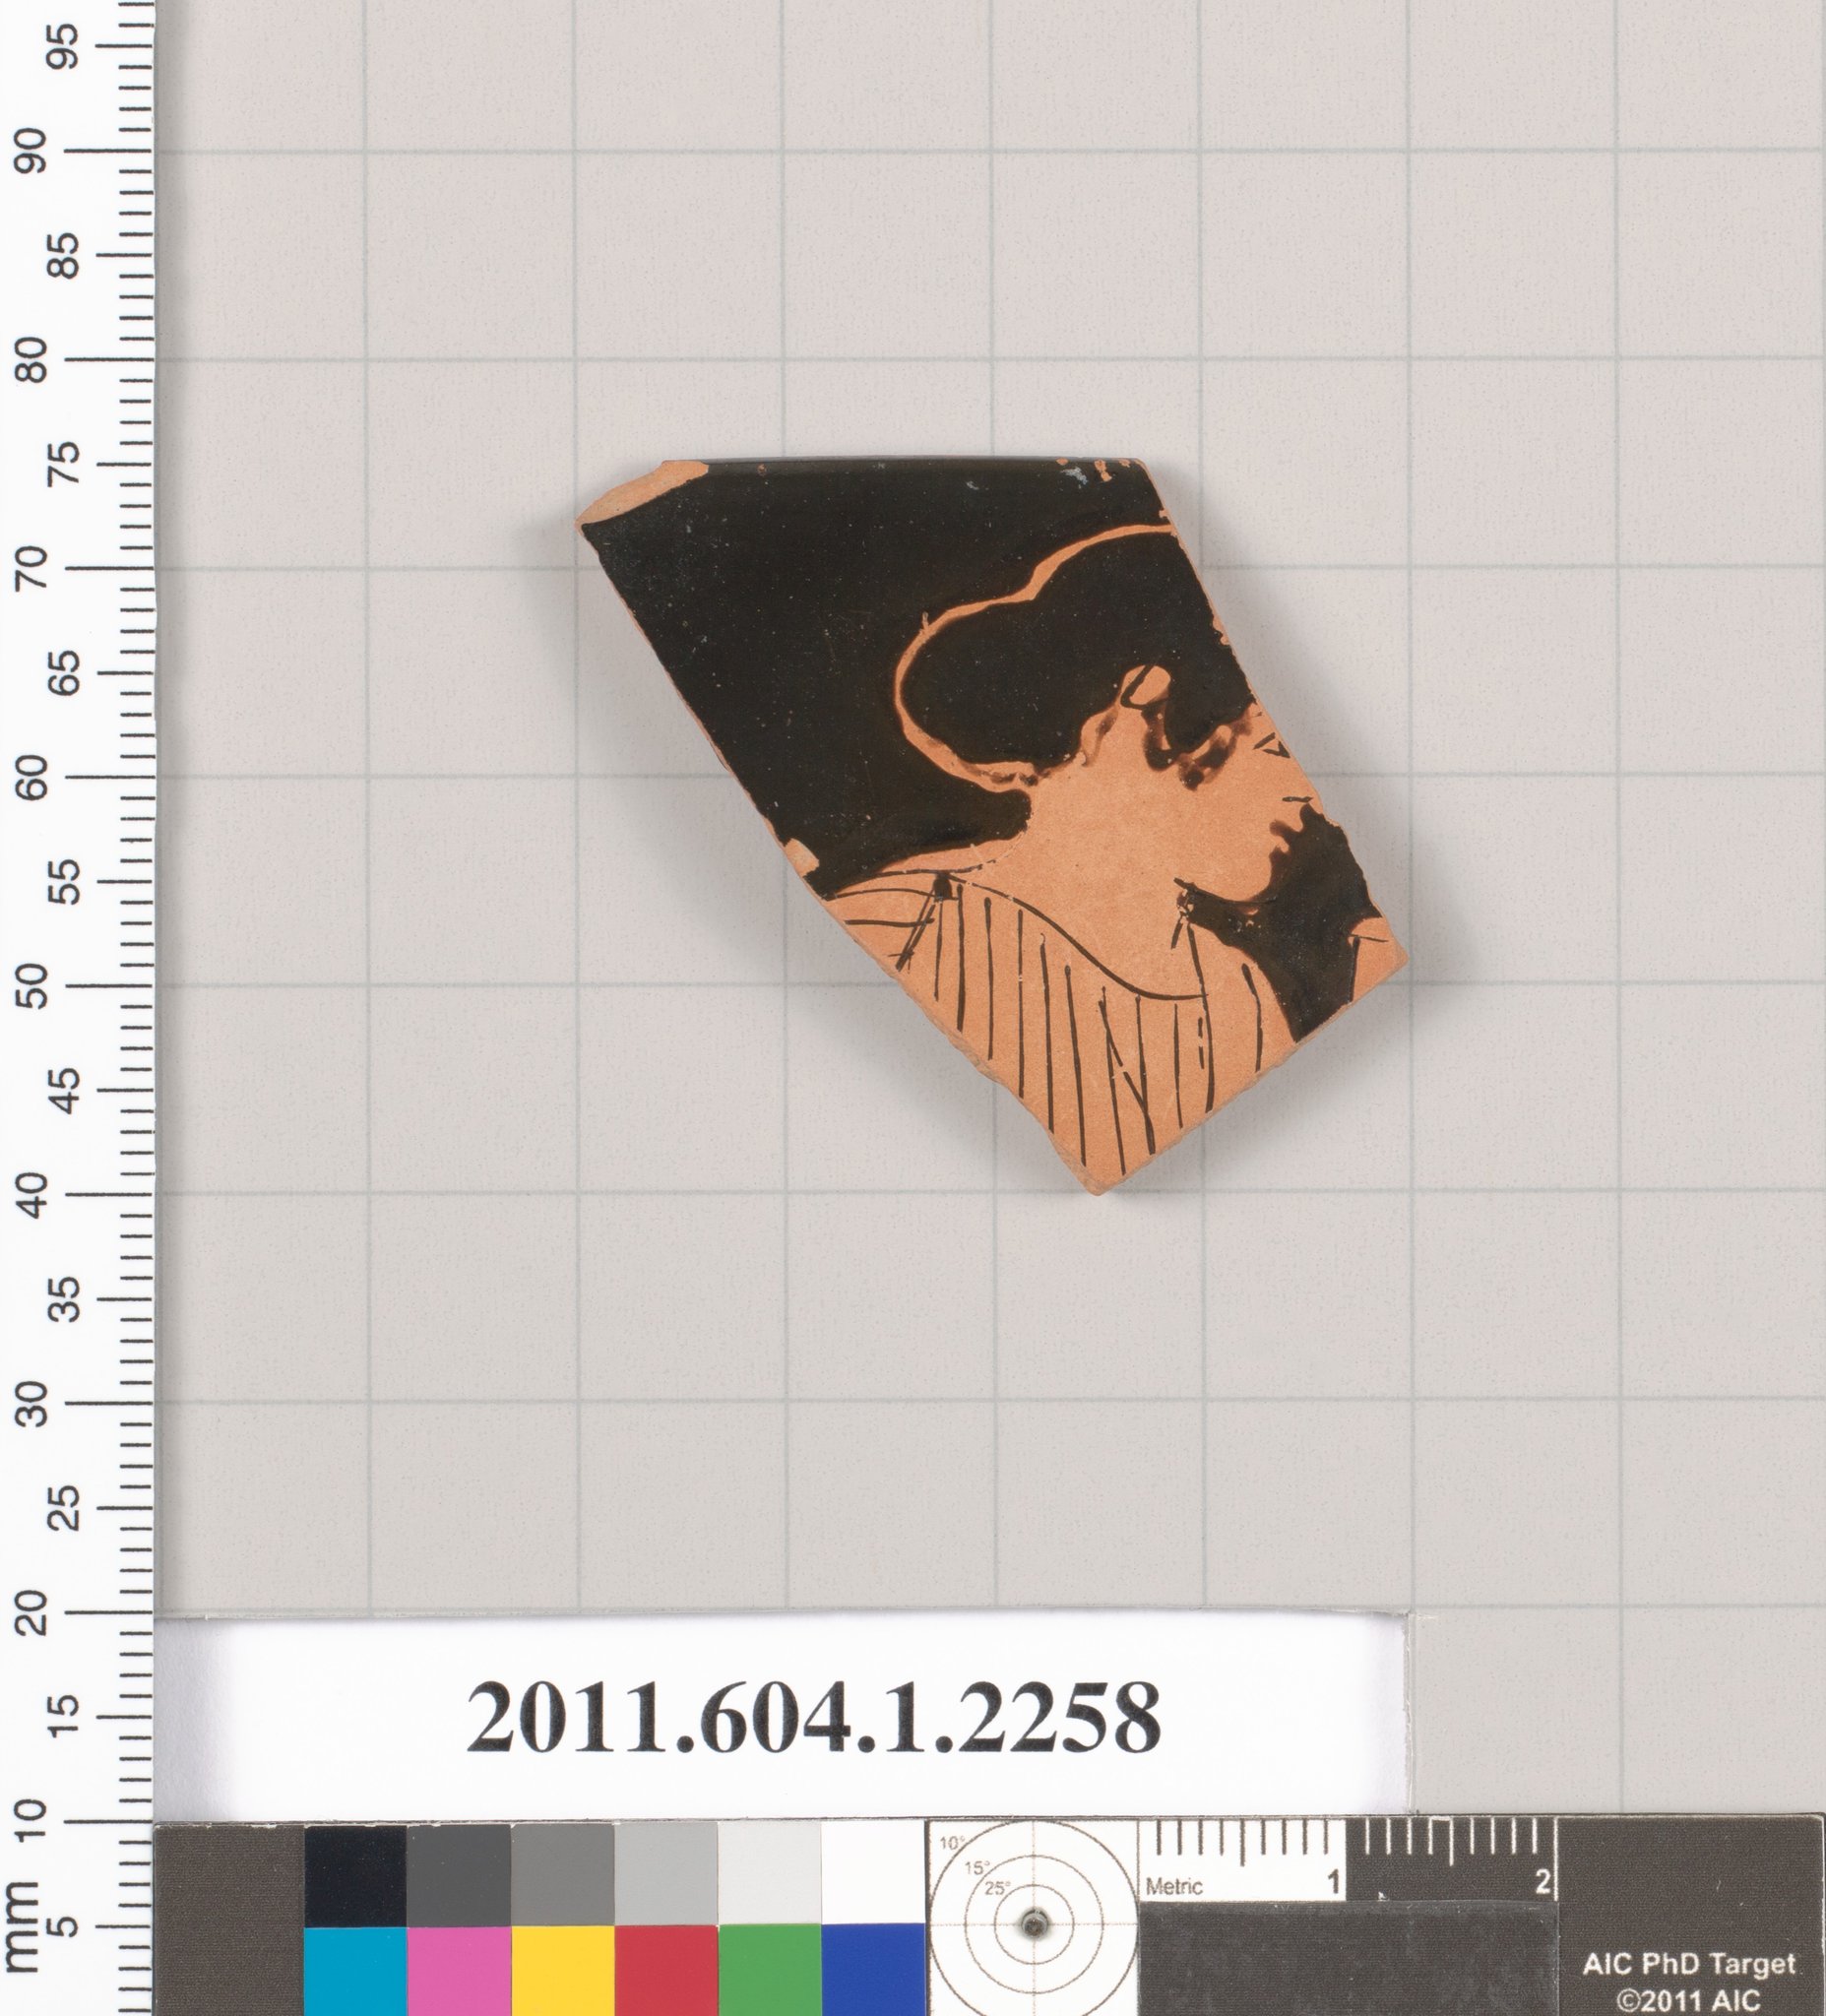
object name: kylix fragment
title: Terracotta rim fragment of a kylix (drinking cup)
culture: greek, attic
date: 460-450 BCE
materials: terracotta